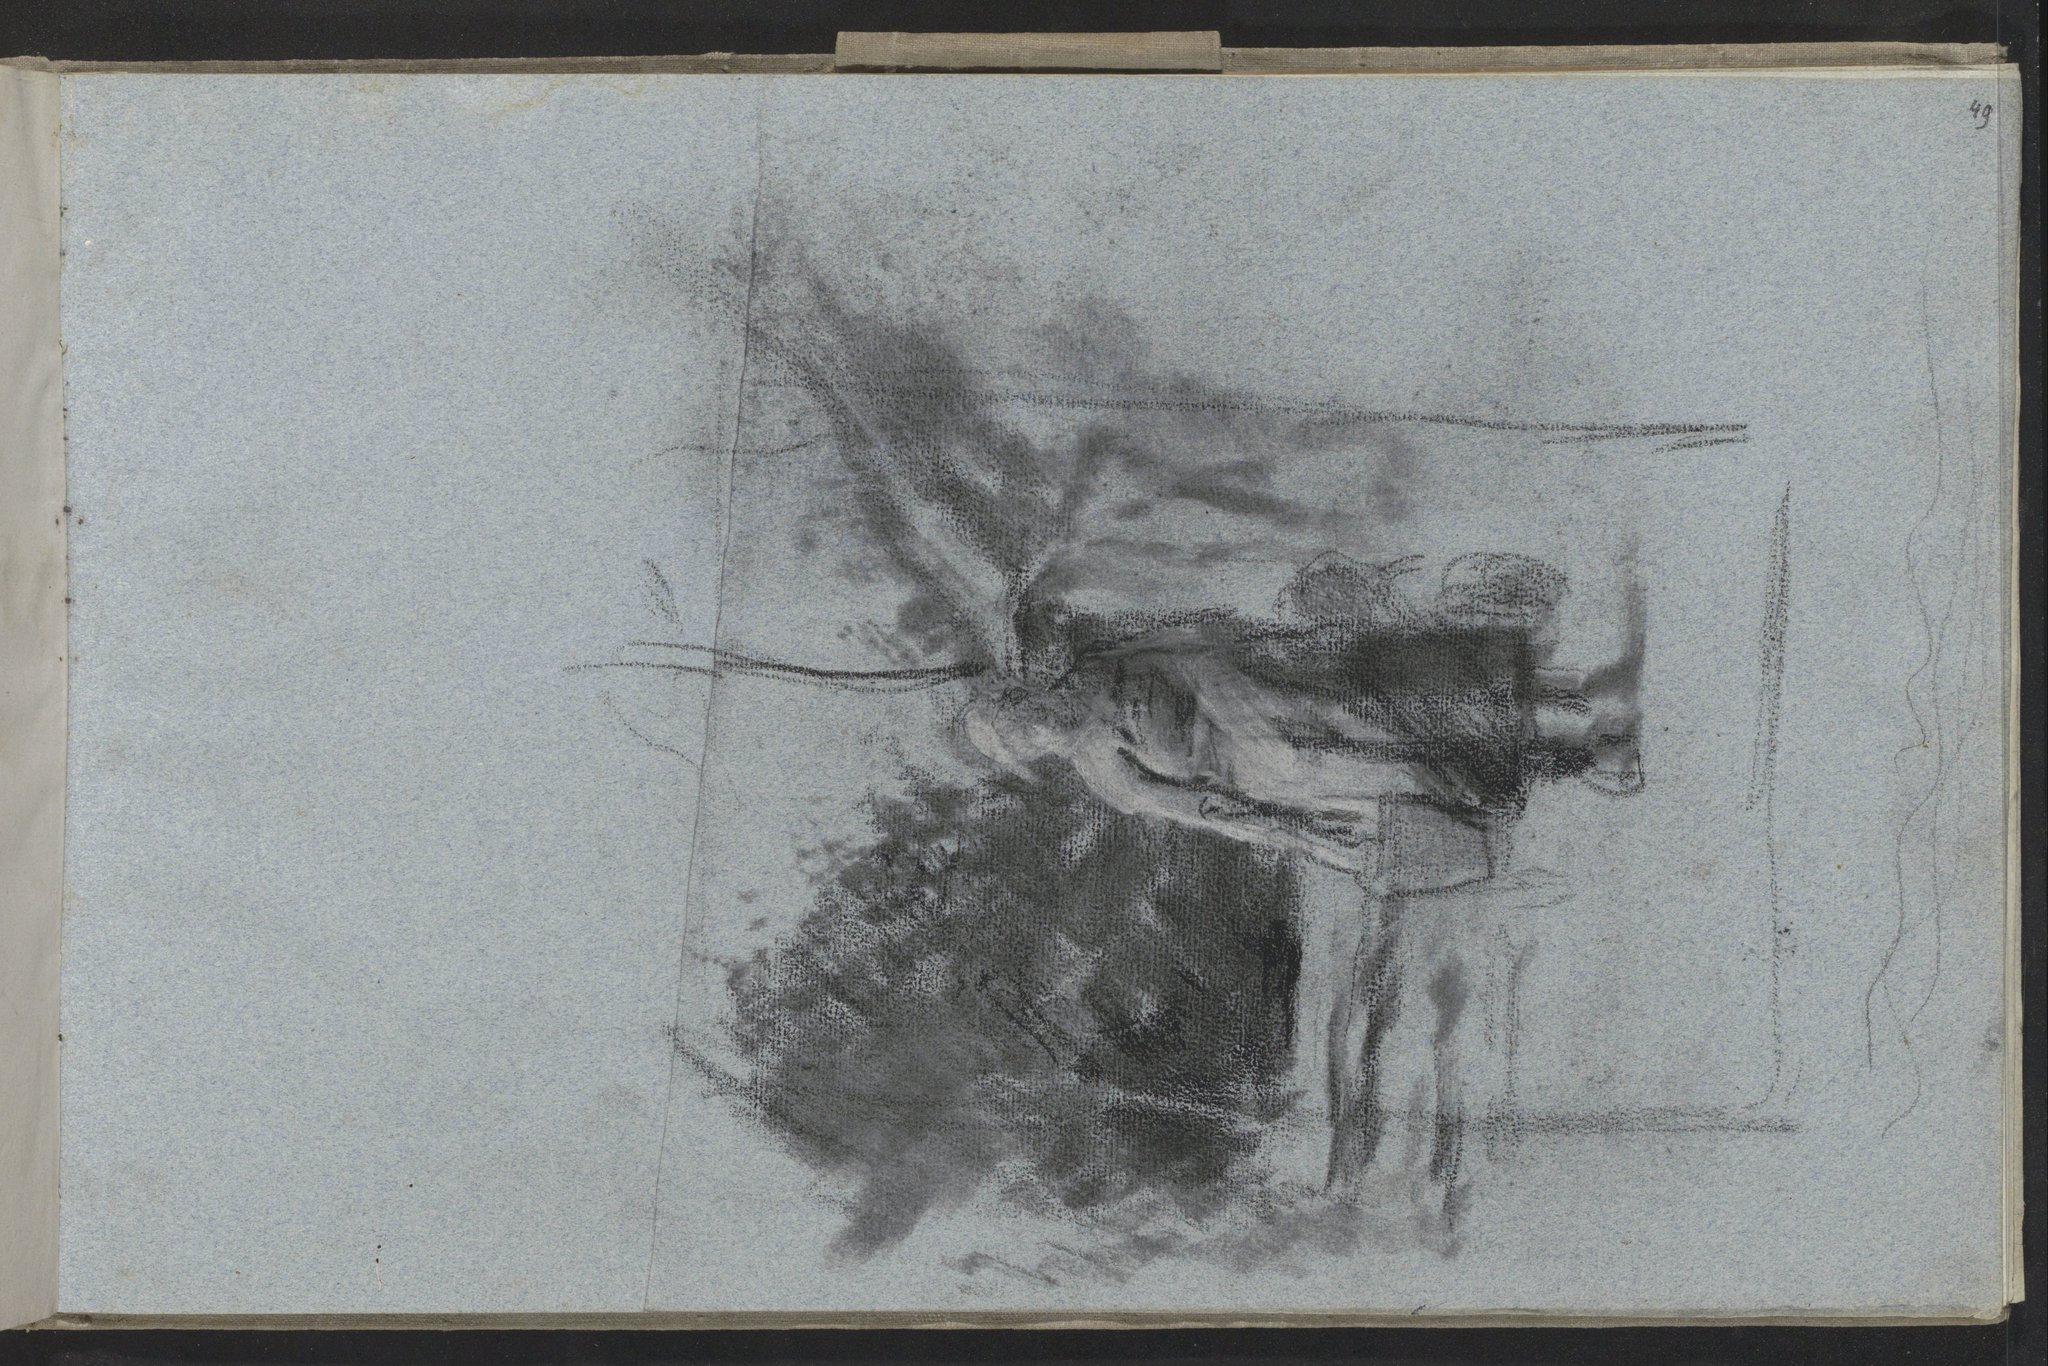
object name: sketchbook leaf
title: Straat met een boerin die emmers draagt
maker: albert neuhuys (1844-1914)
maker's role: draughtsman, painter, print maker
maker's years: 1844-1914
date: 1854-1914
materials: charcoal, paint, paper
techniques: brush, stumping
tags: wooden container: barrel, cask, bucket, farmers - aa - female farmer, farmer's wife, street (+ city(-scape) with figures, staffage)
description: Blad 49 recto uit een schetsboek met 51 bladen.